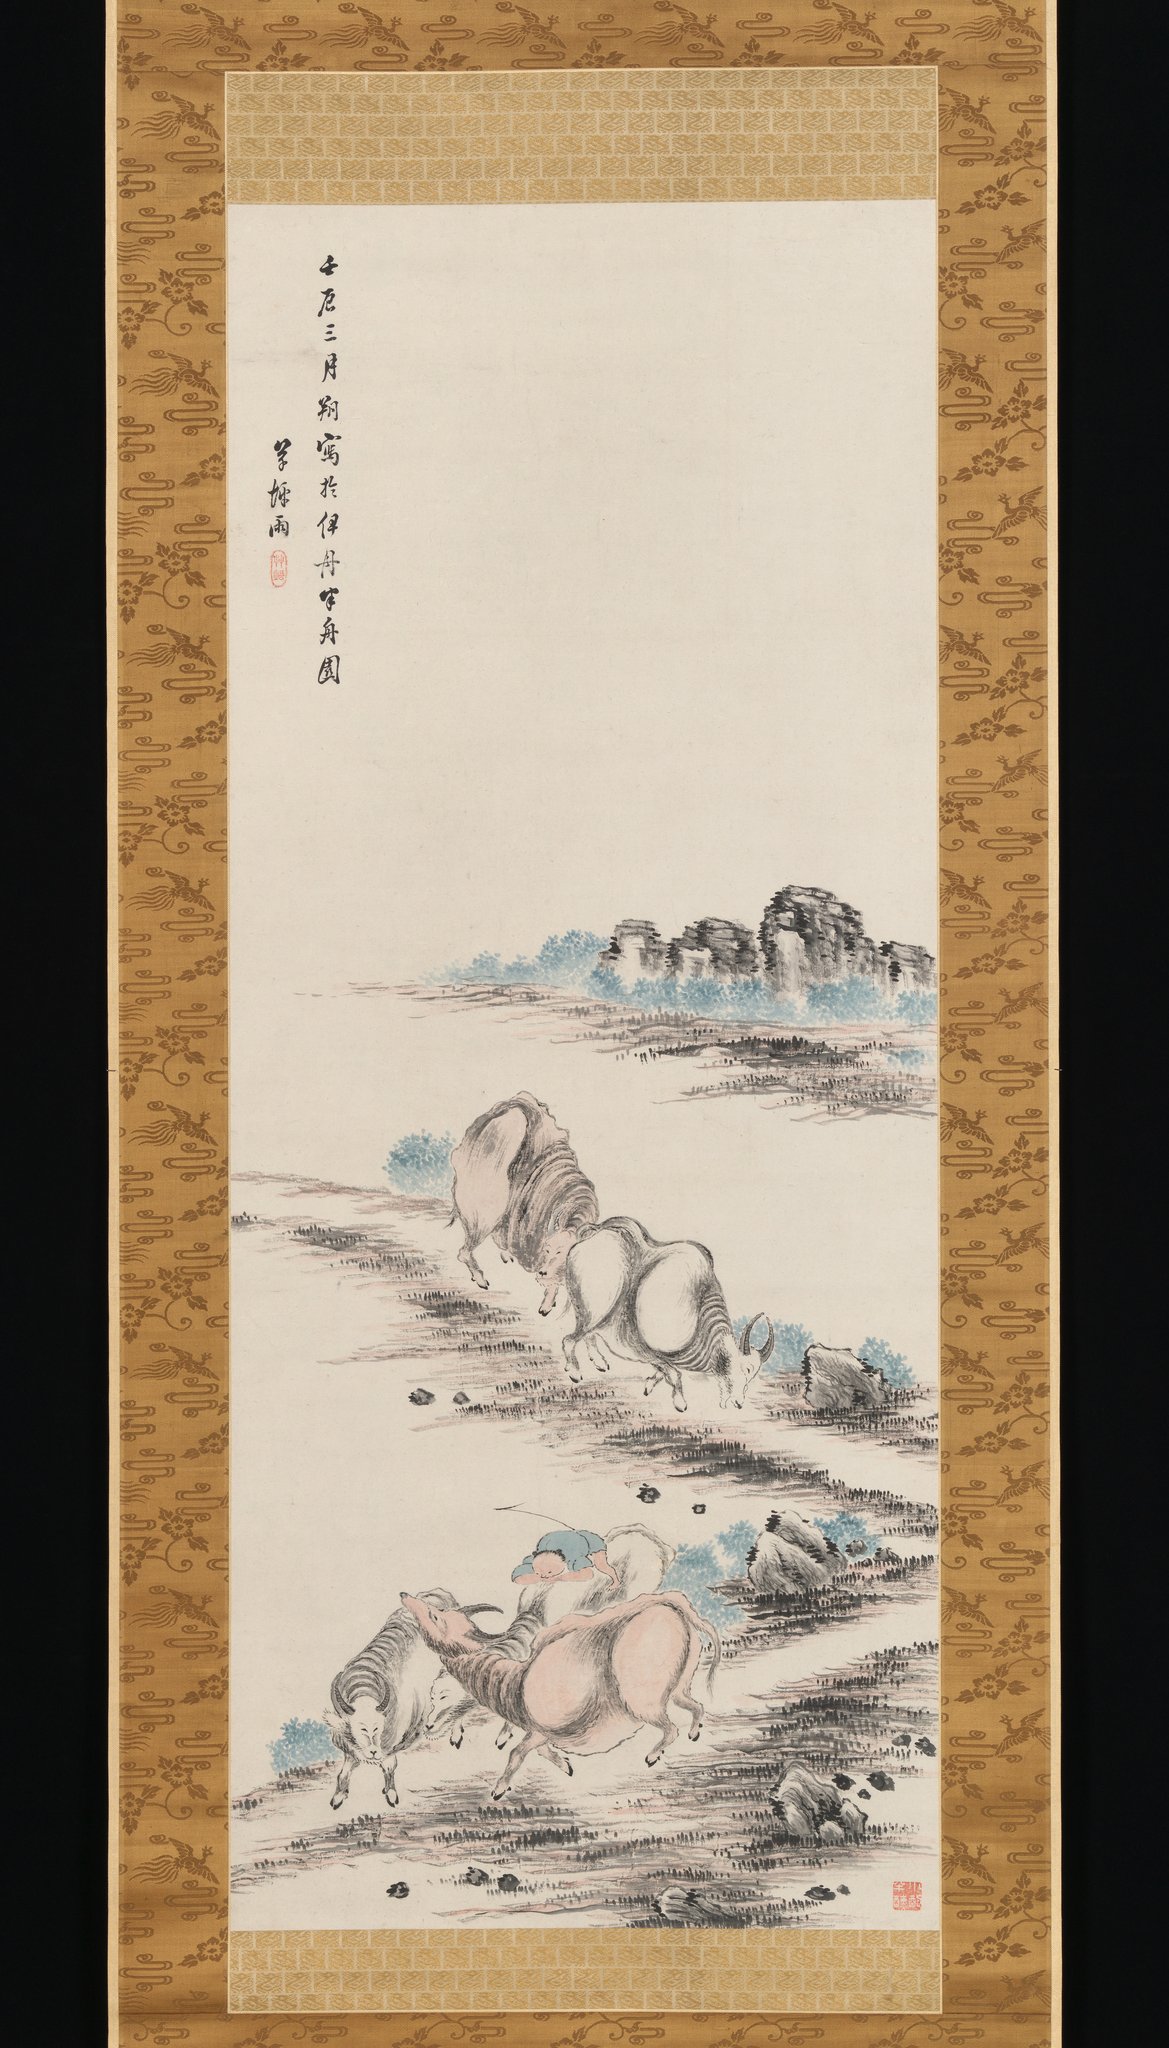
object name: hanging scroll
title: Herdboy and Water Buffaloes Returning Home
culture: japanese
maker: takahashi sōhei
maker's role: artist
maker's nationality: japanese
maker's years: 1804-1835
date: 1832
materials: ink, paper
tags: boys,buffalos